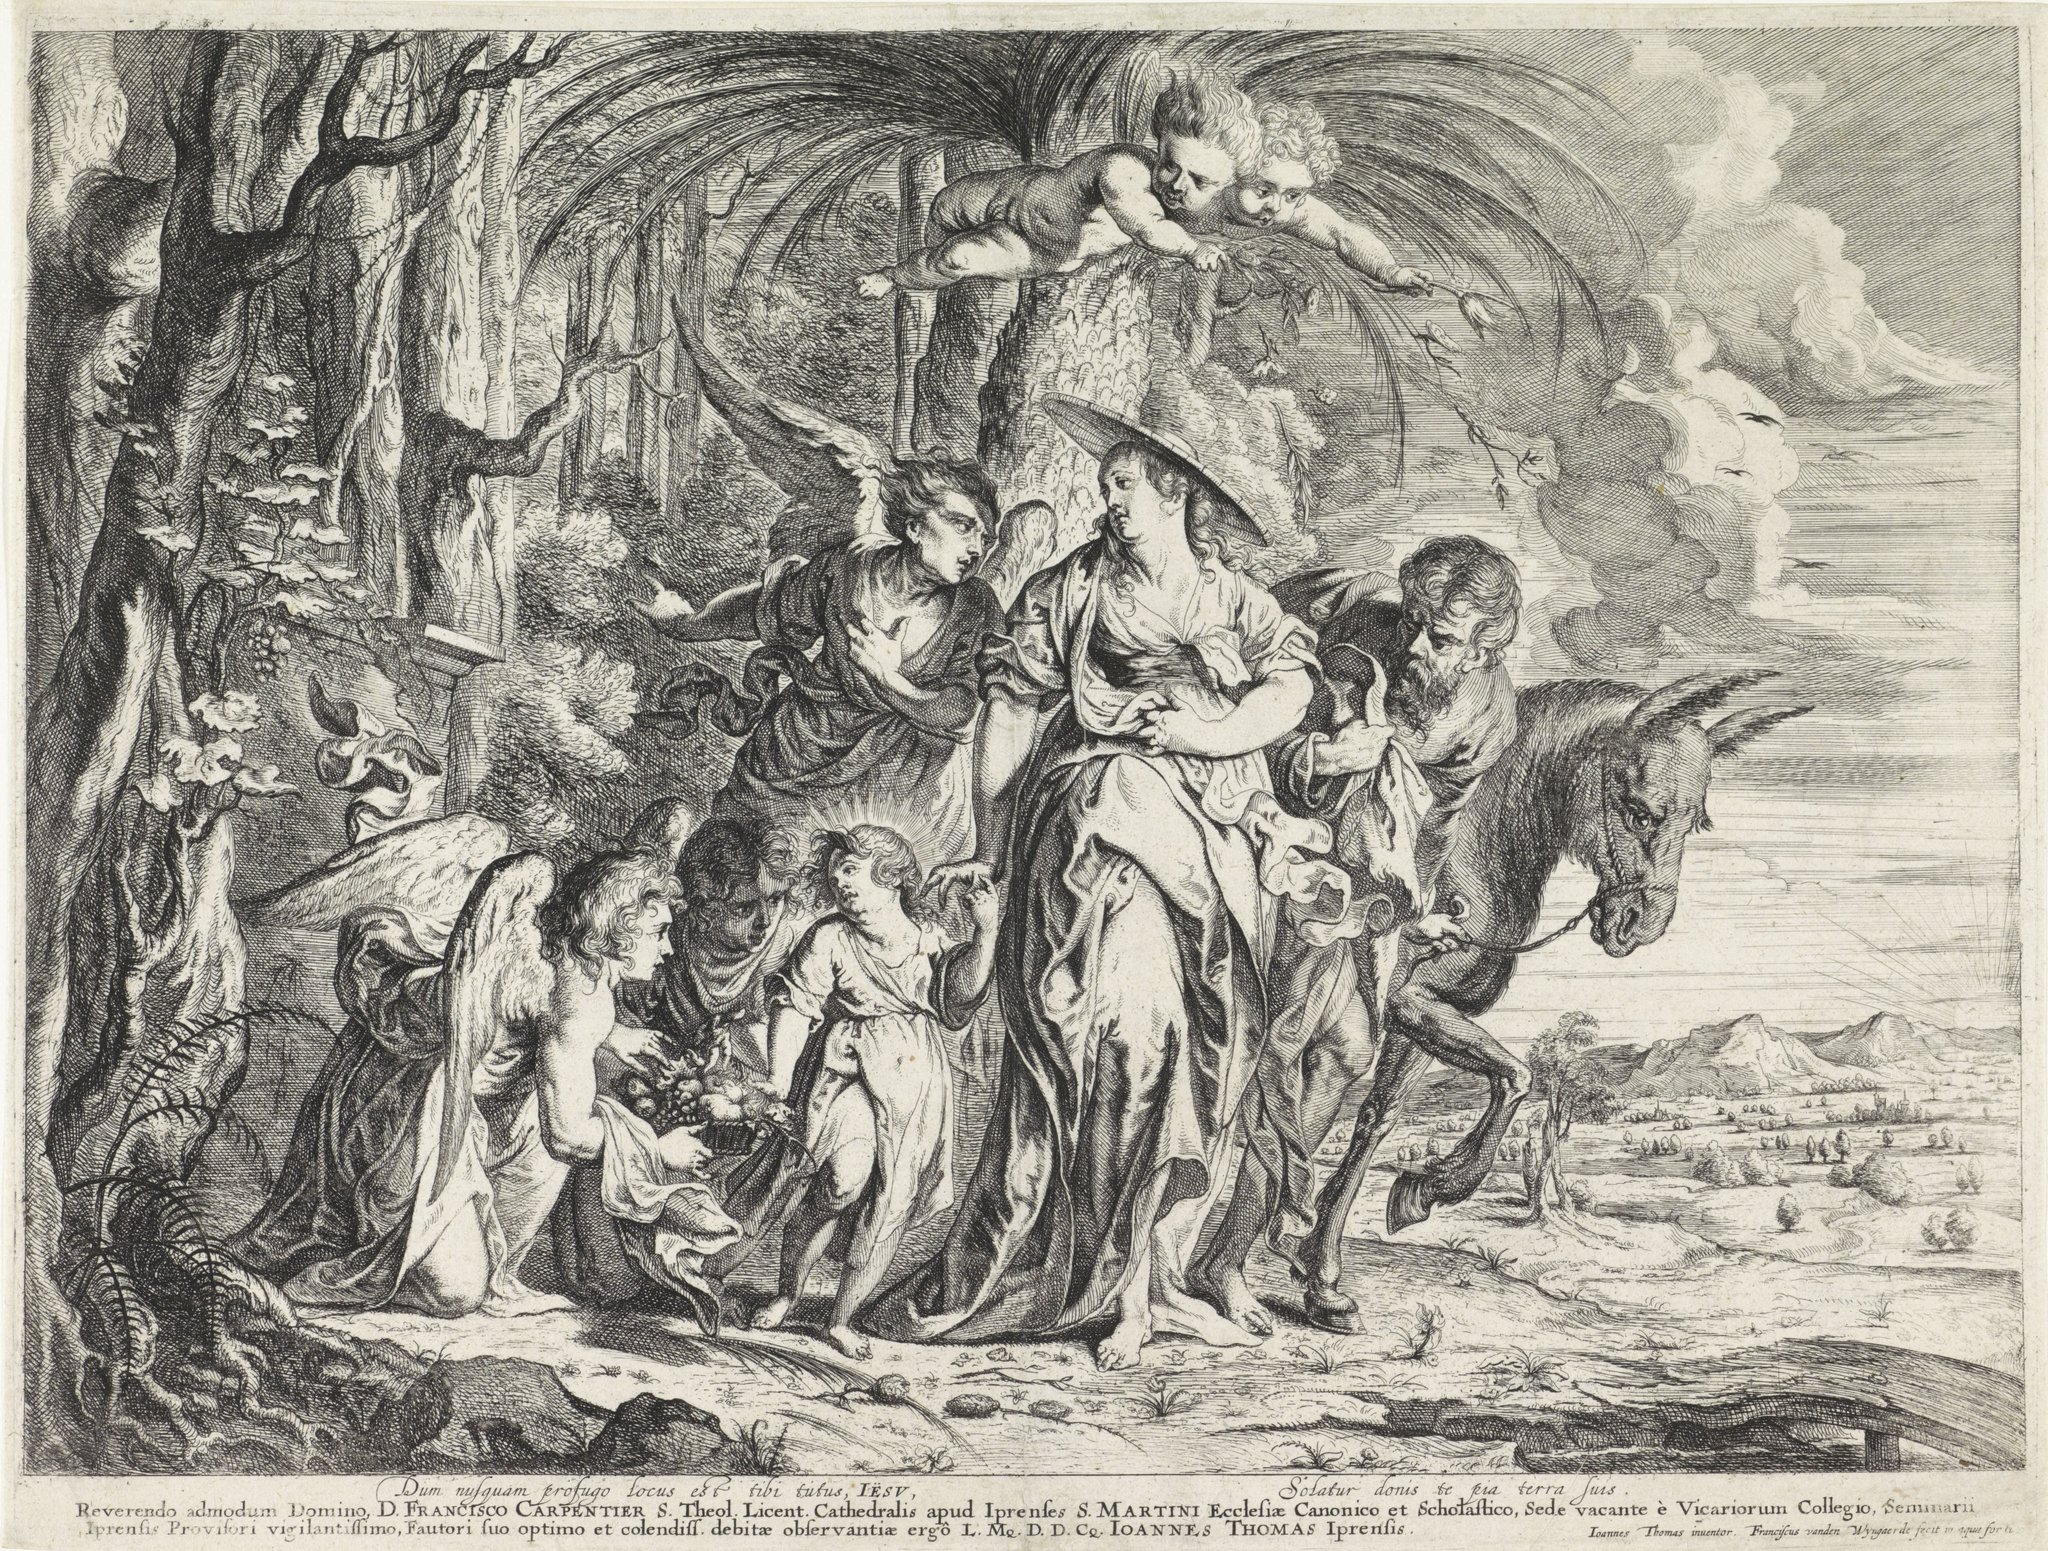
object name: print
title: Vlucht naar Egypte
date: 1636-1679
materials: paper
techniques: etching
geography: antwerp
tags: the flight into egypt: mary, joseph, the child (and sometimes others) on their way; mary usually riding on an ass (+ angel(s))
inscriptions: collector's mark: Lugt 240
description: De Heilige Familie vlucht naar Egypte. Jozef loopt voorop met de ezel aan de teugels. Maria volgt met het Christuskind aan de hand. Twee engelen knielen voor Christus en bieden hem een mand met fruit aan. In de marge twee regels in het Latijn en een onderschrift met een opdracht in het Latijn.